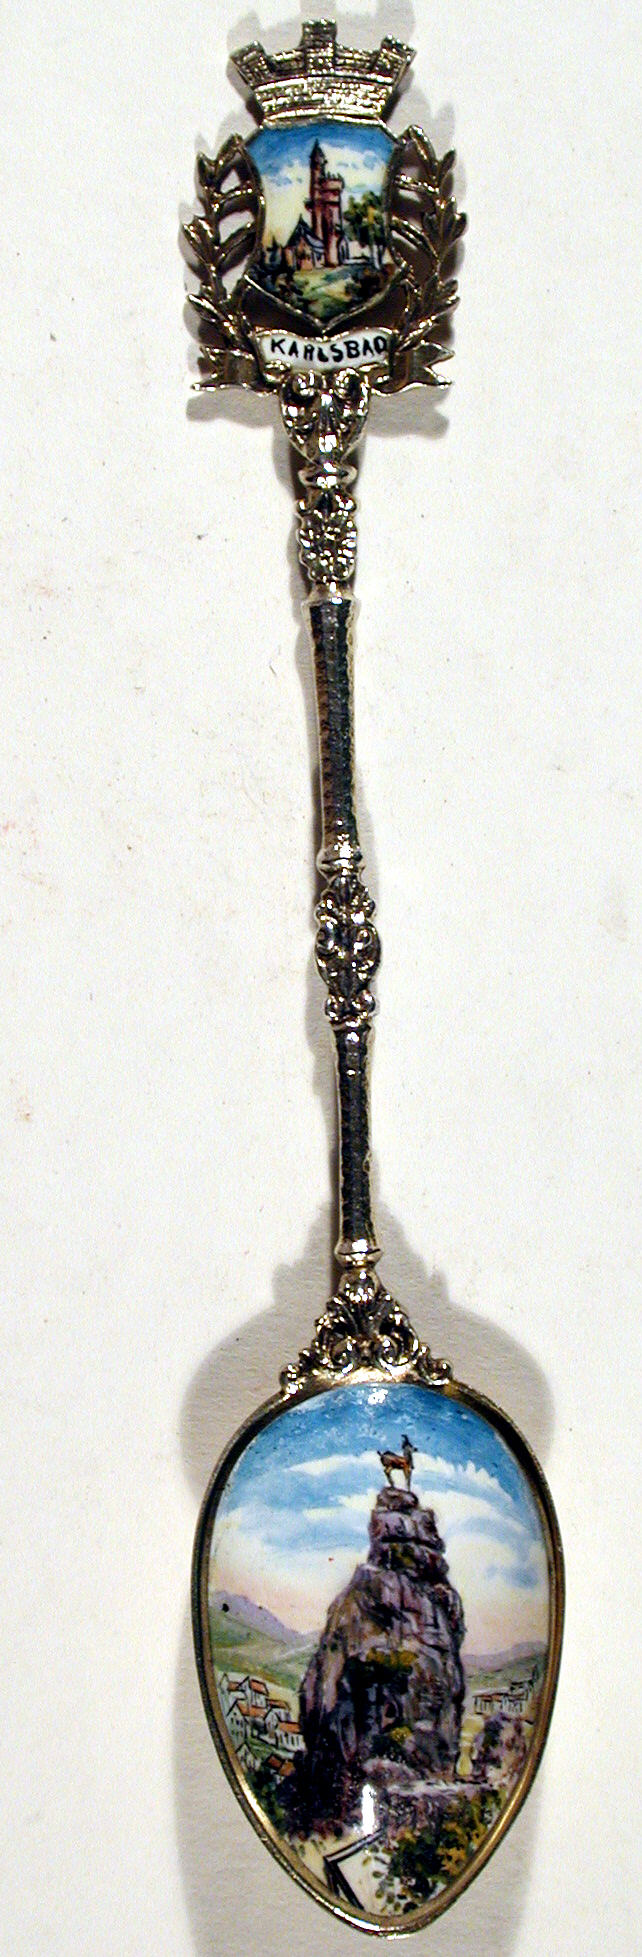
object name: souvenir spoon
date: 1867-1900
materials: enamel, silver gilt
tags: houses,deer,coat of arms